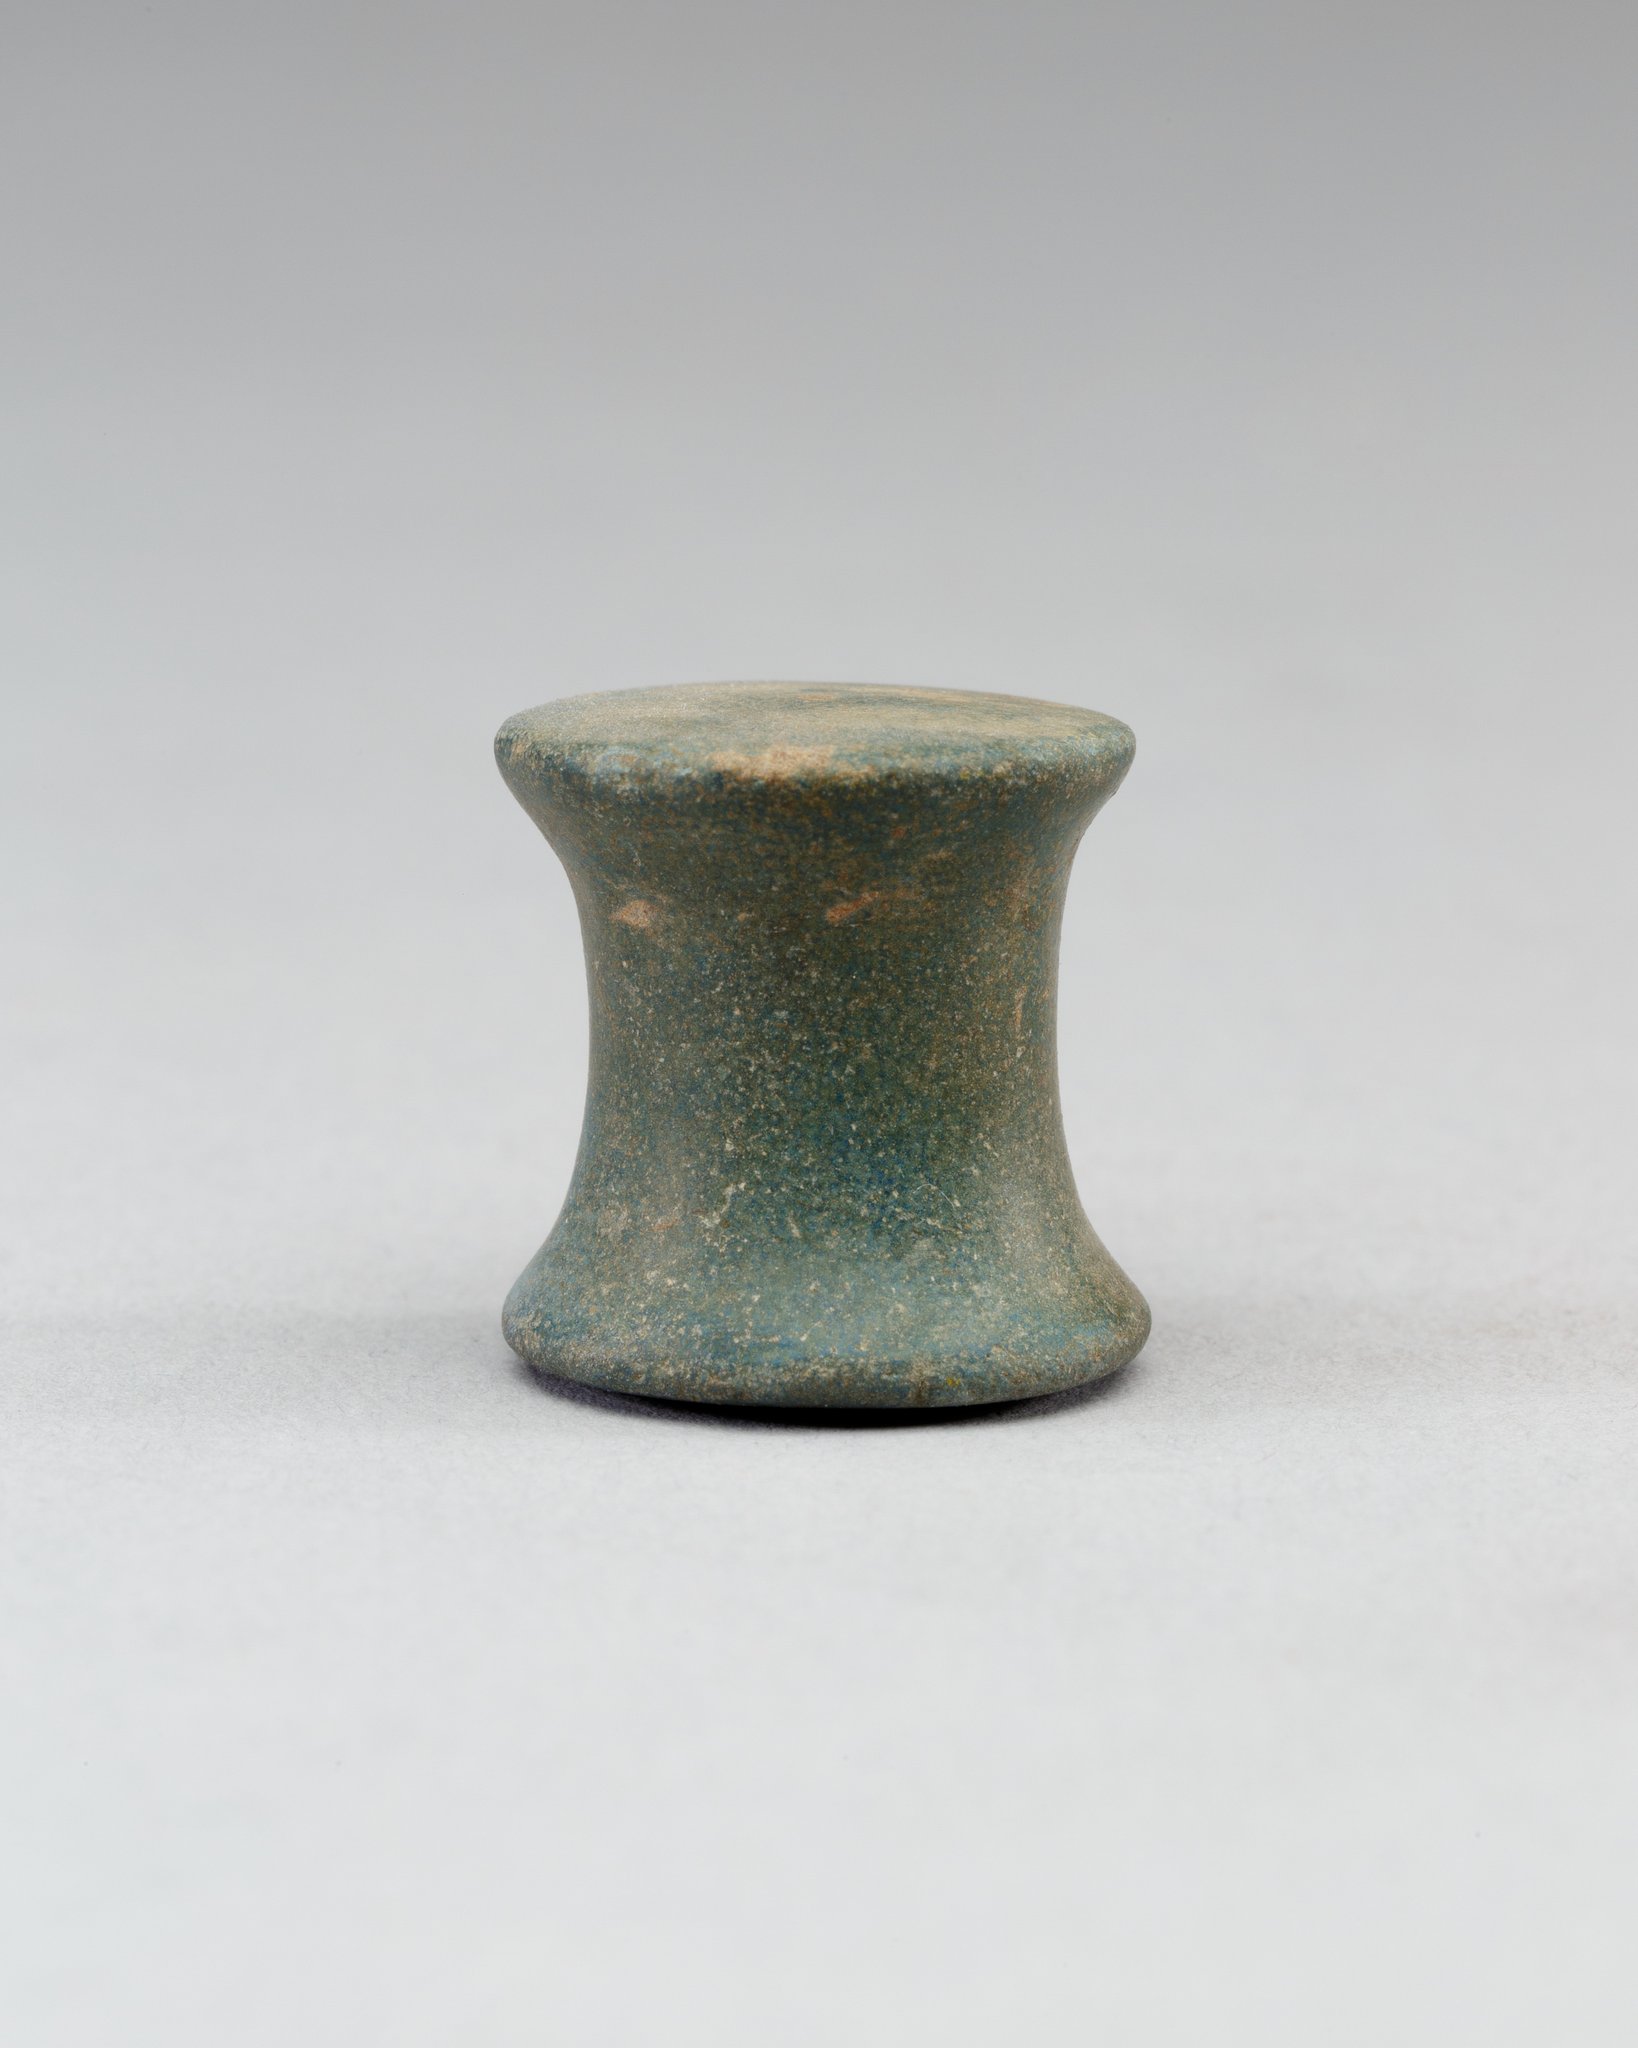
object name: game piece, spool, burial 8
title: Spool-Shaped Game Pieces from Neferkhawet's Tomb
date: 1504-1447 BCE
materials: faience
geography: egypt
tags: games